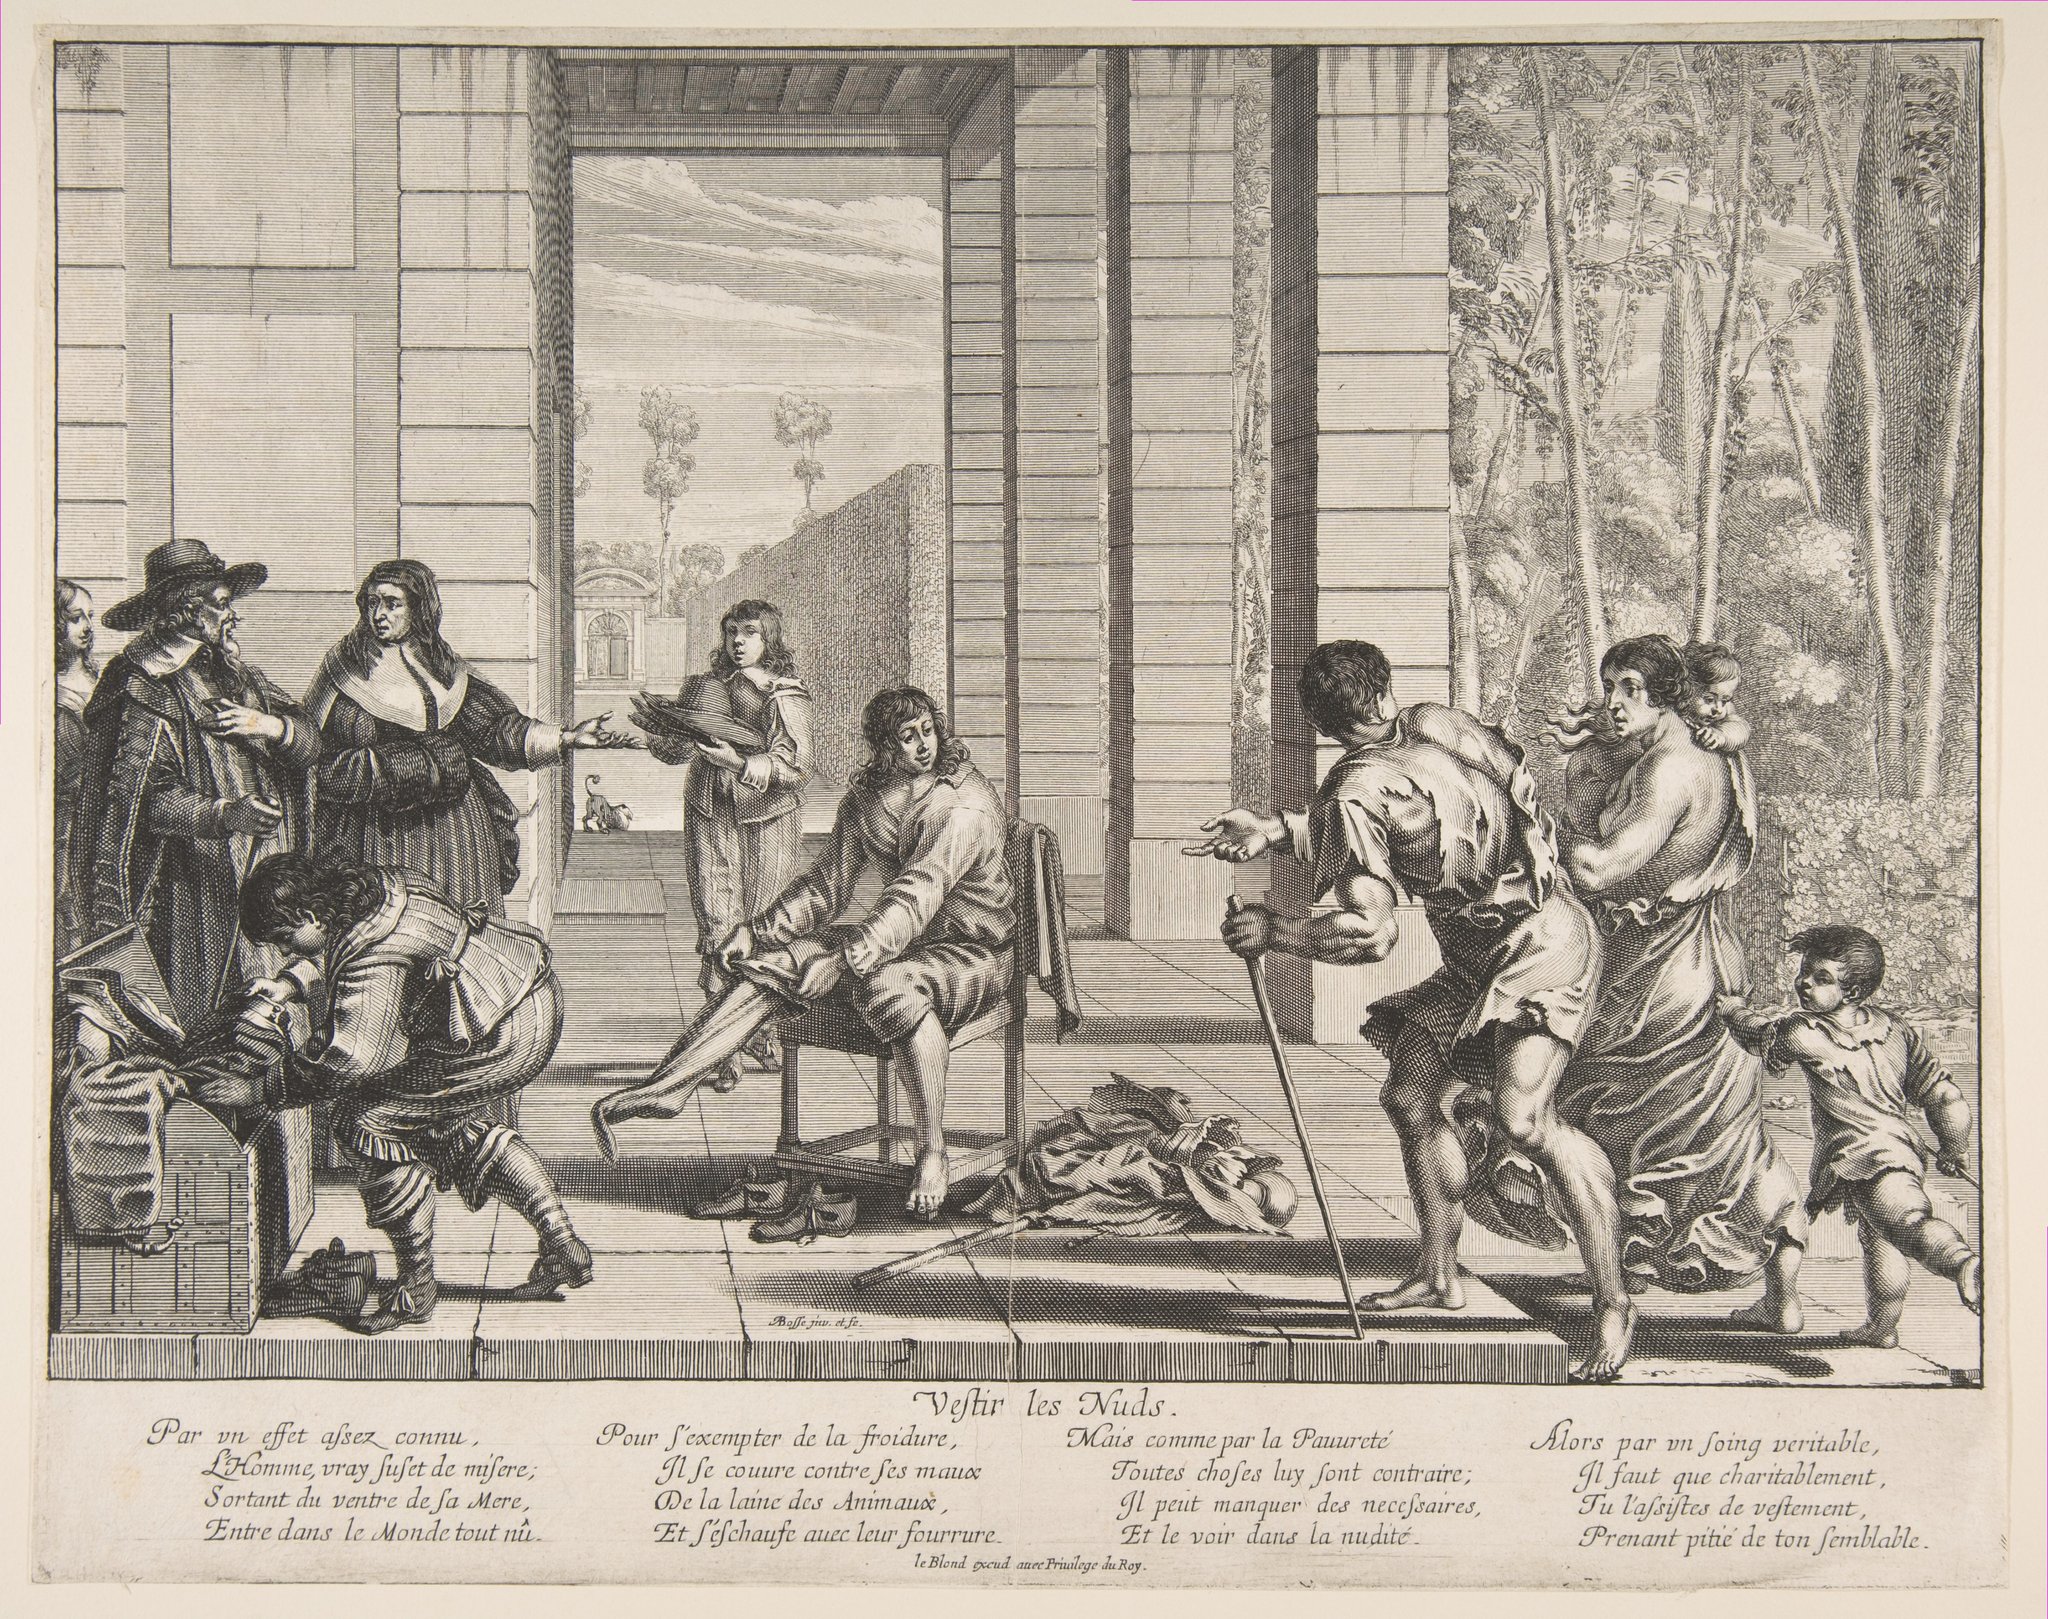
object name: print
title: Clothing Beggars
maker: abraham bosse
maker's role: artist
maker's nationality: french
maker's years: 1602-1676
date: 1635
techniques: etching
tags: children,men,women,dressing